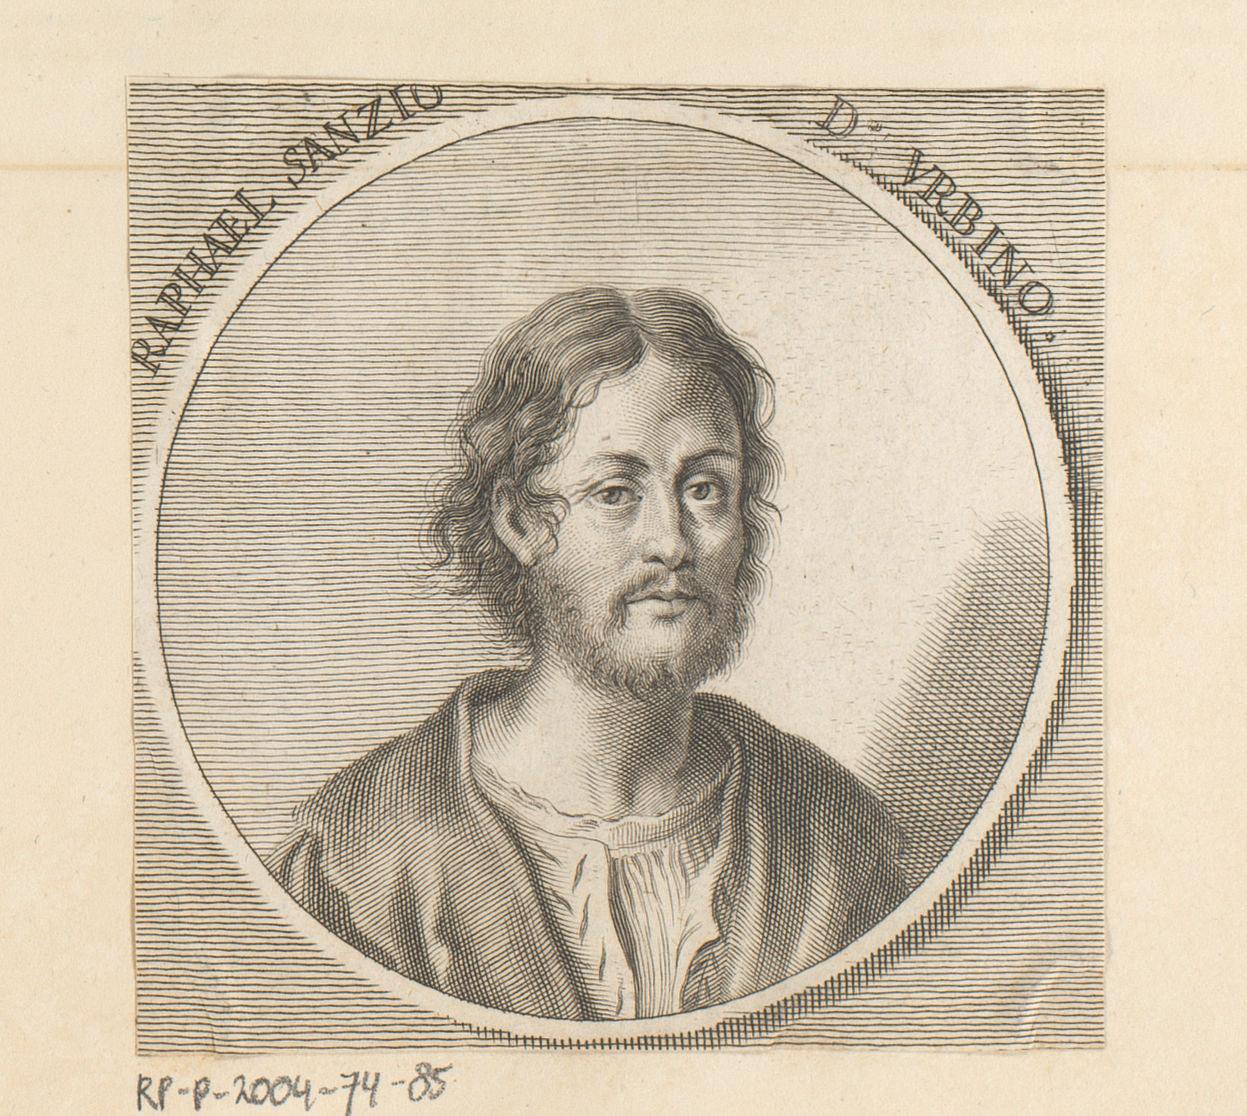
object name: book illustration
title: Portret van Rafaël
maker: philipp kilian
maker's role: print maker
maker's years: 1628-1693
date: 1768-1775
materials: paper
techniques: engraving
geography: nuremberg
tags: rome, painter, rafaël, historical persons, portrait, self-portrait of painter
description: Prent uit: Sandrart, Joachim von. Teutsche Academie der Bau- Bildhauer- und Maler-Kunst: worinn die Regeln und Lehrsätze dieser Künste gegeben. 14 dln. Neurenberg: erven Johann Andreas Endter, [1774], dl. 7, p. N. De samensteller heeft deze prent in het album geplakt als illustratie bij: Pilkington, Matthew en Johann Heinrich Füssli. A dictionary of painters, from the revival of the art to the present period. 4 dln. Londen: John Crowder, 1805, dl. 3, p. 494.